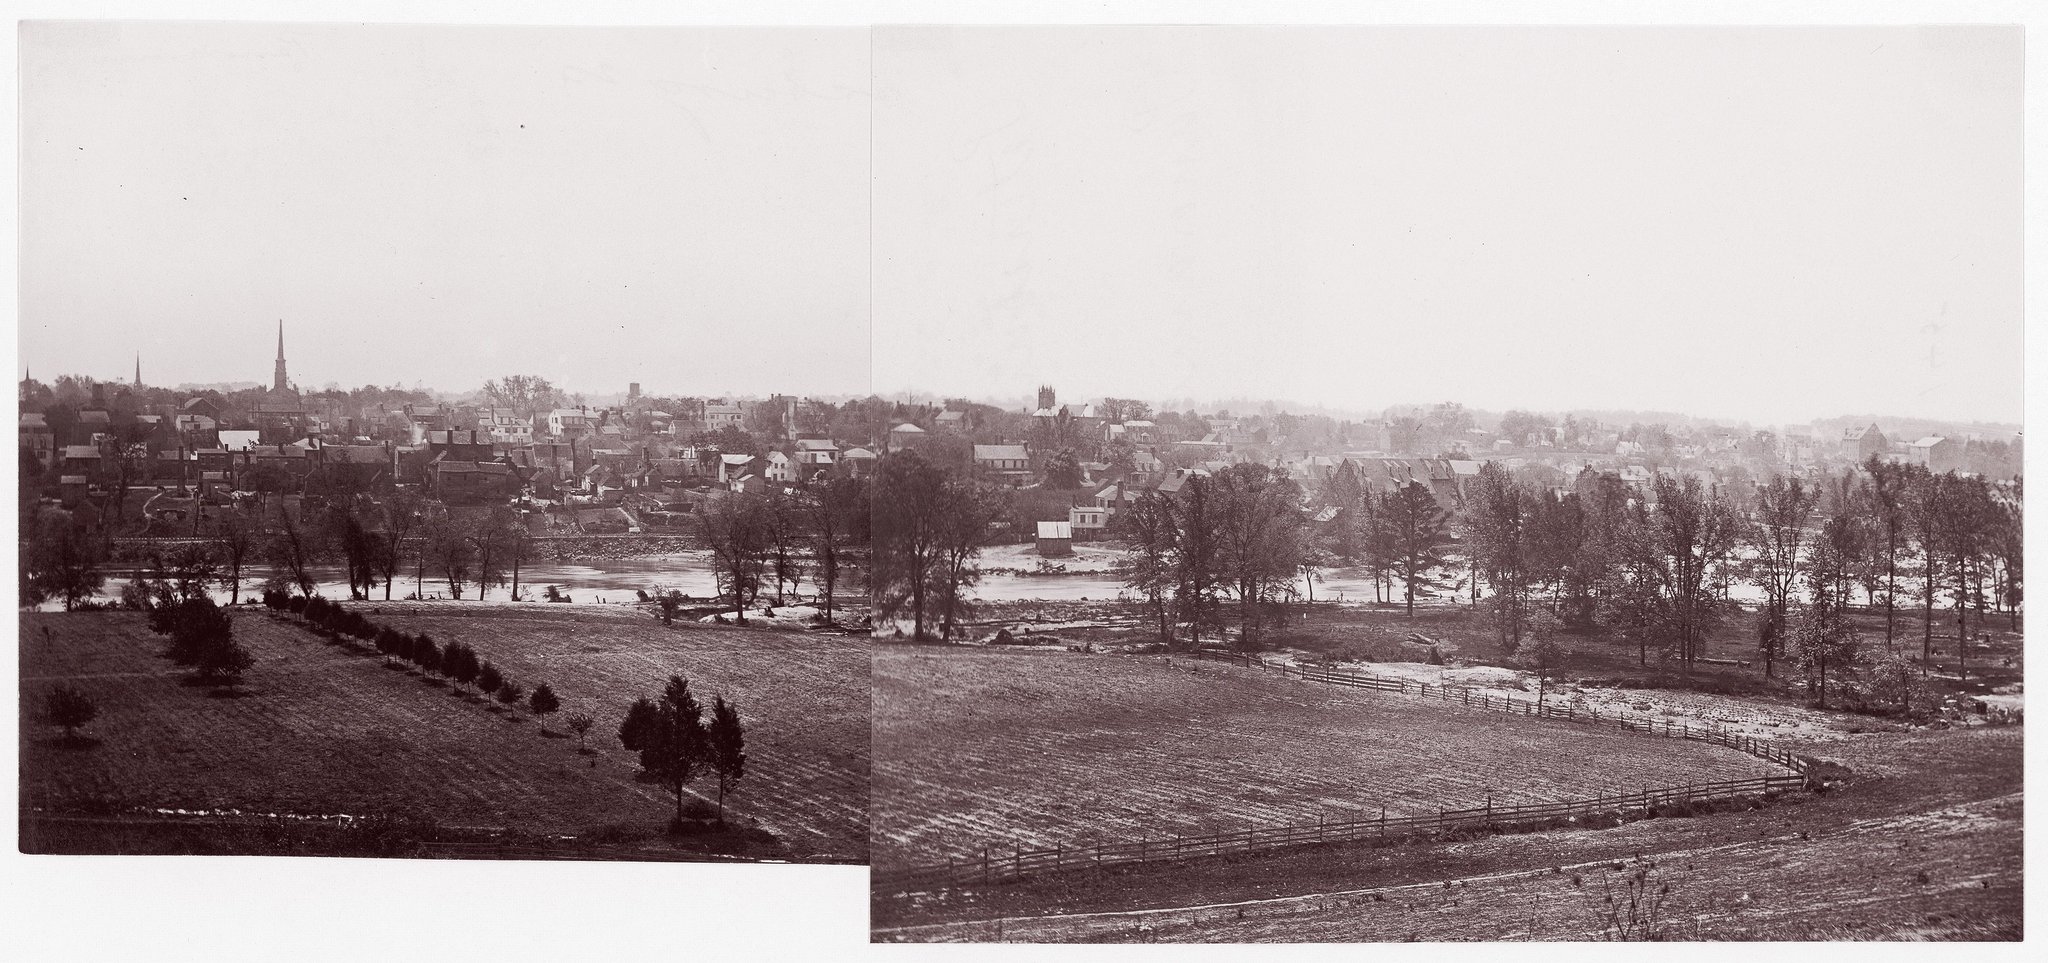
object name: photograph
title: [Petersburg, Virginia]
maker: timothy h. o'sullivan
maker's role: artist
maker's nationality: american, born ireland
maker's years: 1840-1882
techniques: albumen silver print, glass negative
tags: american civil war,landscapes